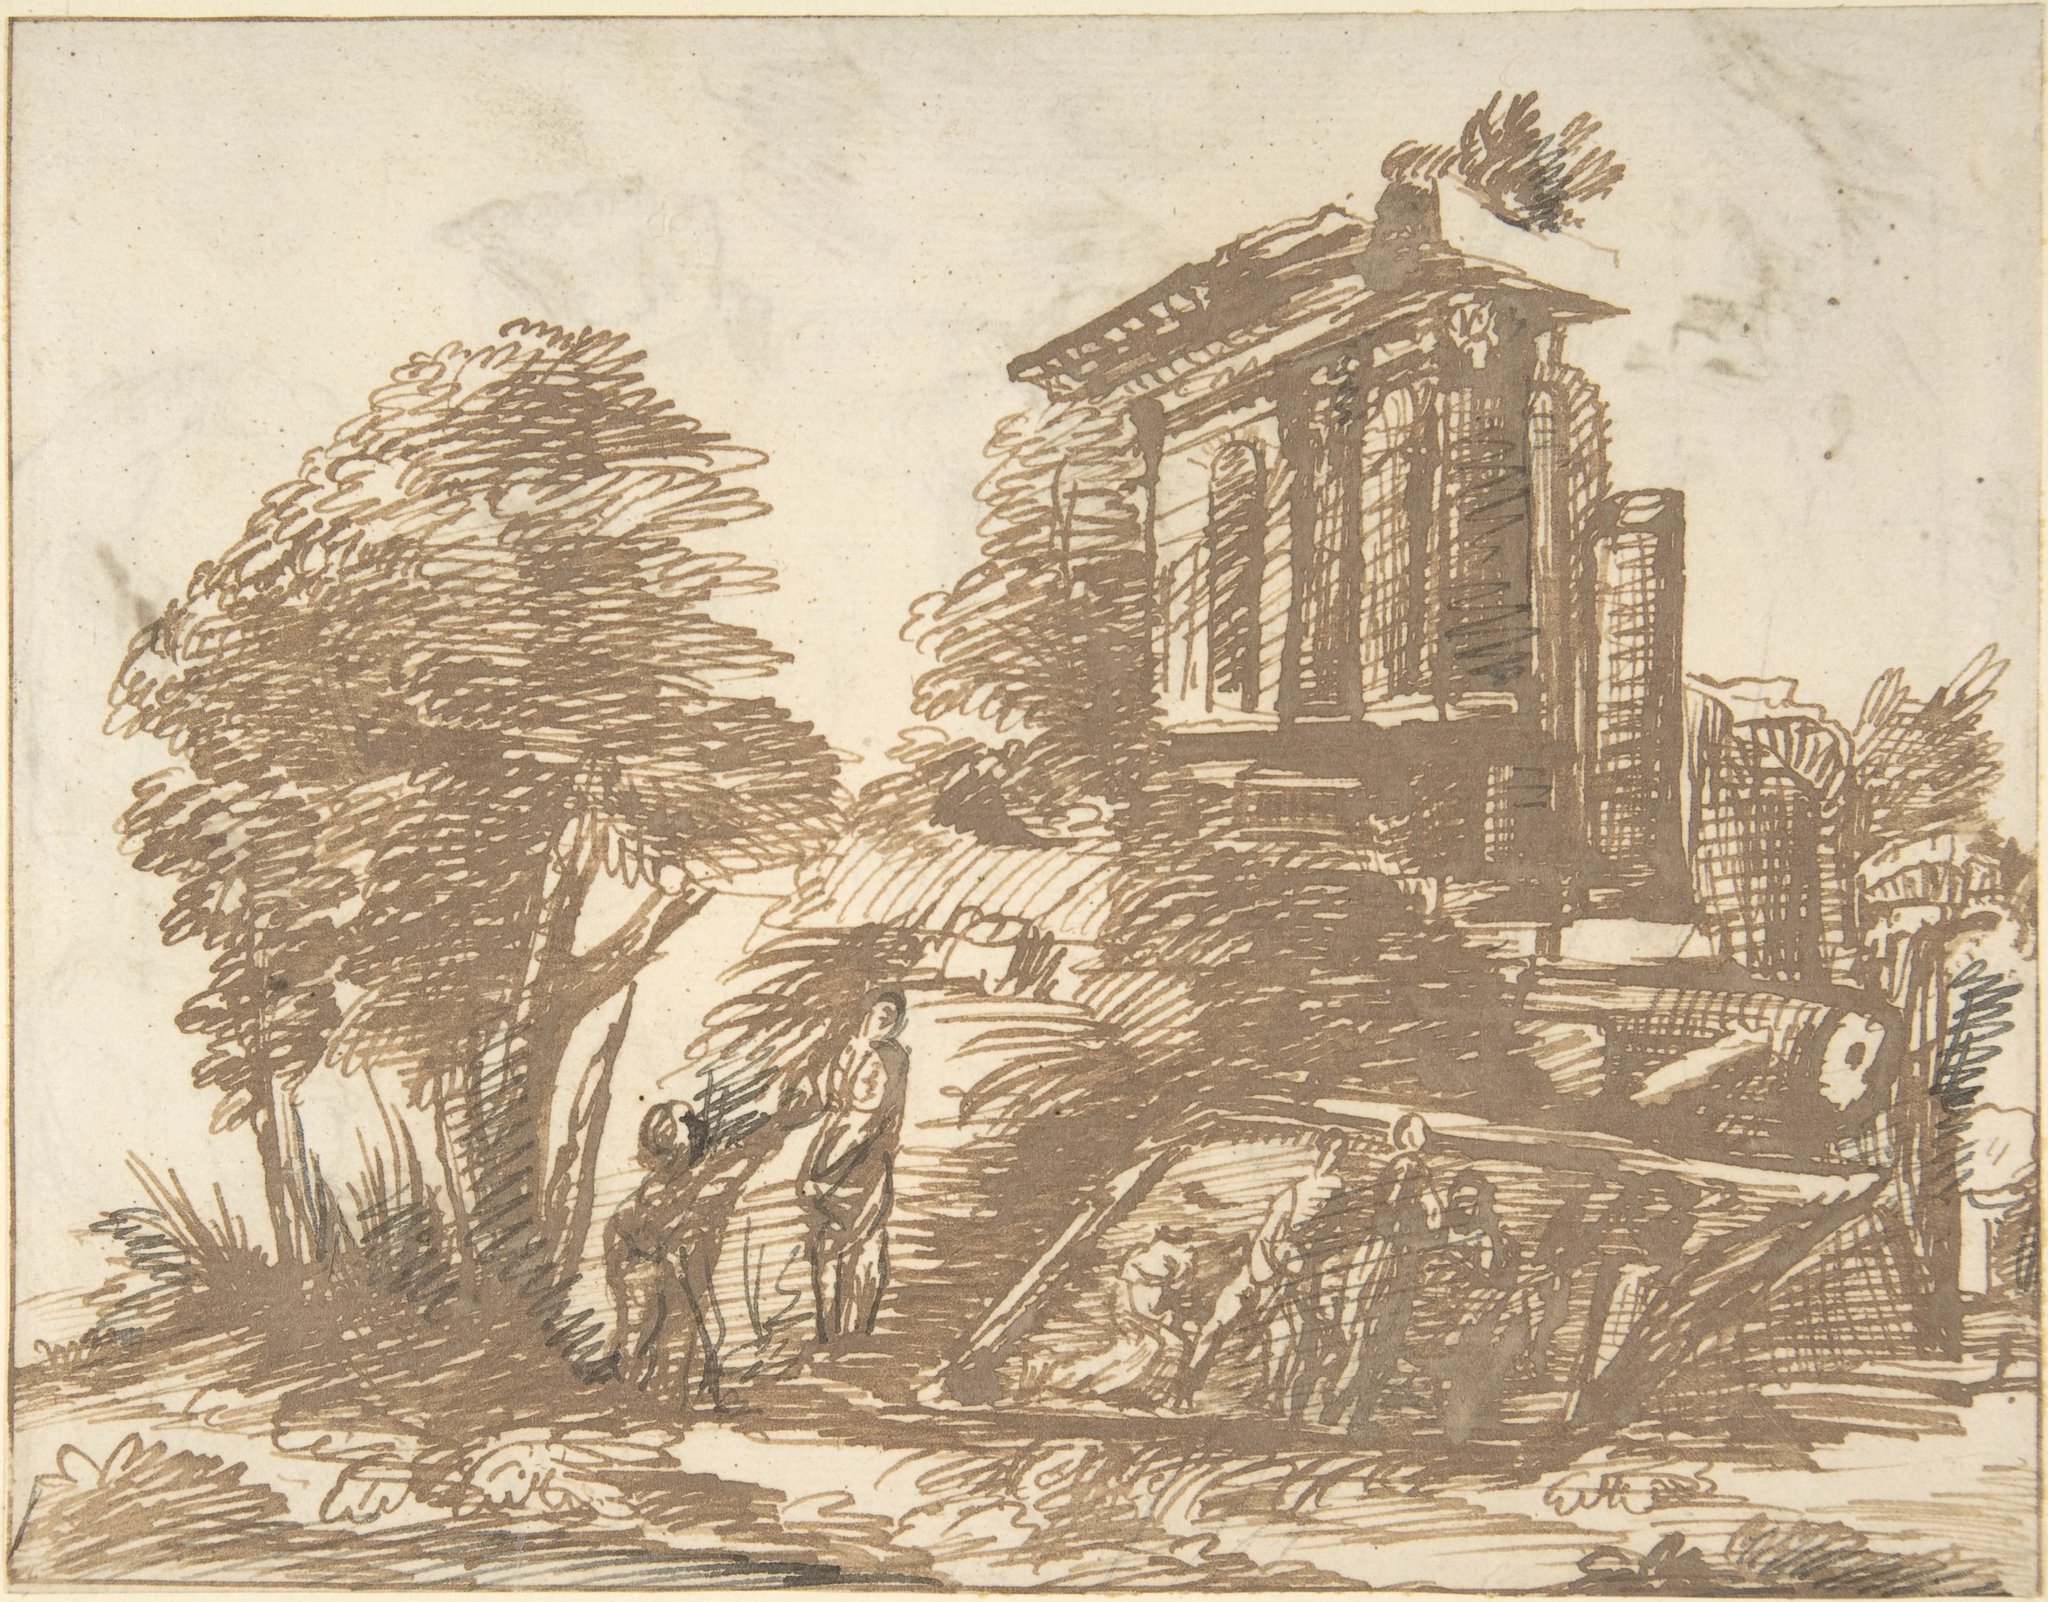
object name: drawing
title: Figures in a Landscape with Classical Ruins (recto); Six Figure Studies (verso)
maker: anonymous, italian, roman-bolognese, 17th century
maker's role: artist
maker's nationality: italian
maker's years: 1600-1700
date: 1601-1700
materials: ink, paper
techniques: pen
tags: human figures,ruins,landscapes,trees